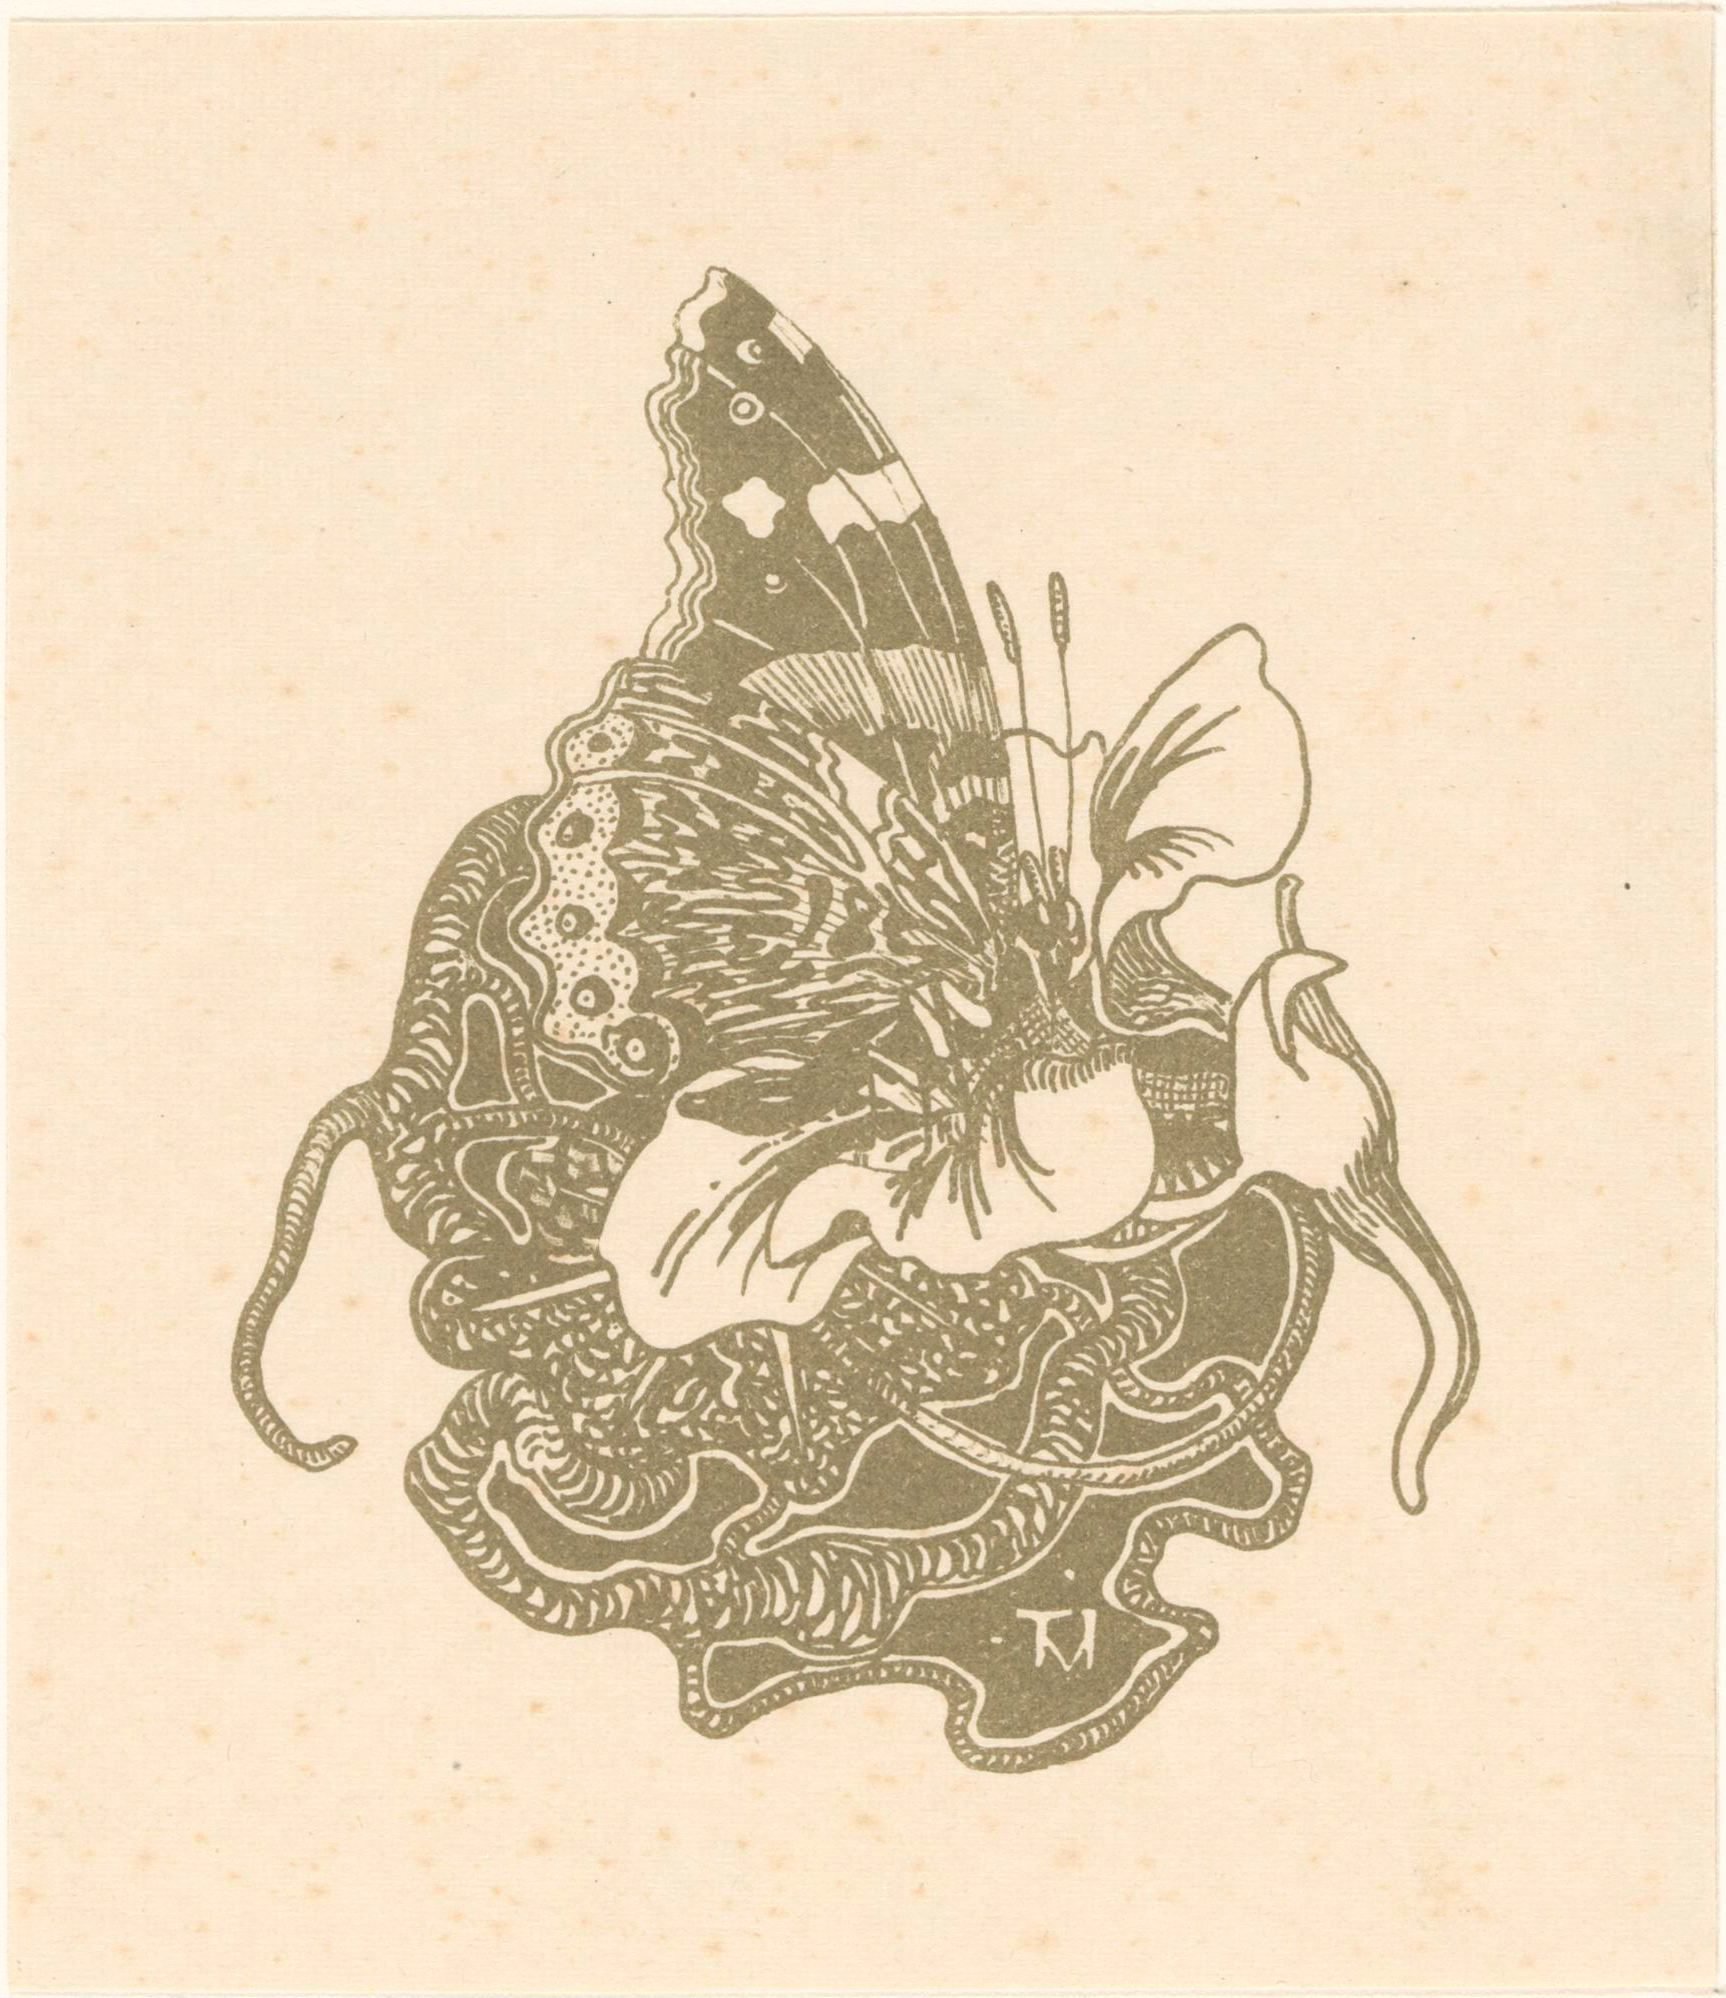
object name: print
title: Vlinder op een Oost-Indische kersbloem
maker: theo van hoytema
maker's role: draughtsman, painter, print maker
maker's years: 1863-1917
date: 1896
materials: paper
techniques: lithograph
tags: flowers, insects: butterfly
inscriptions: collector's mark: Lugt 2228